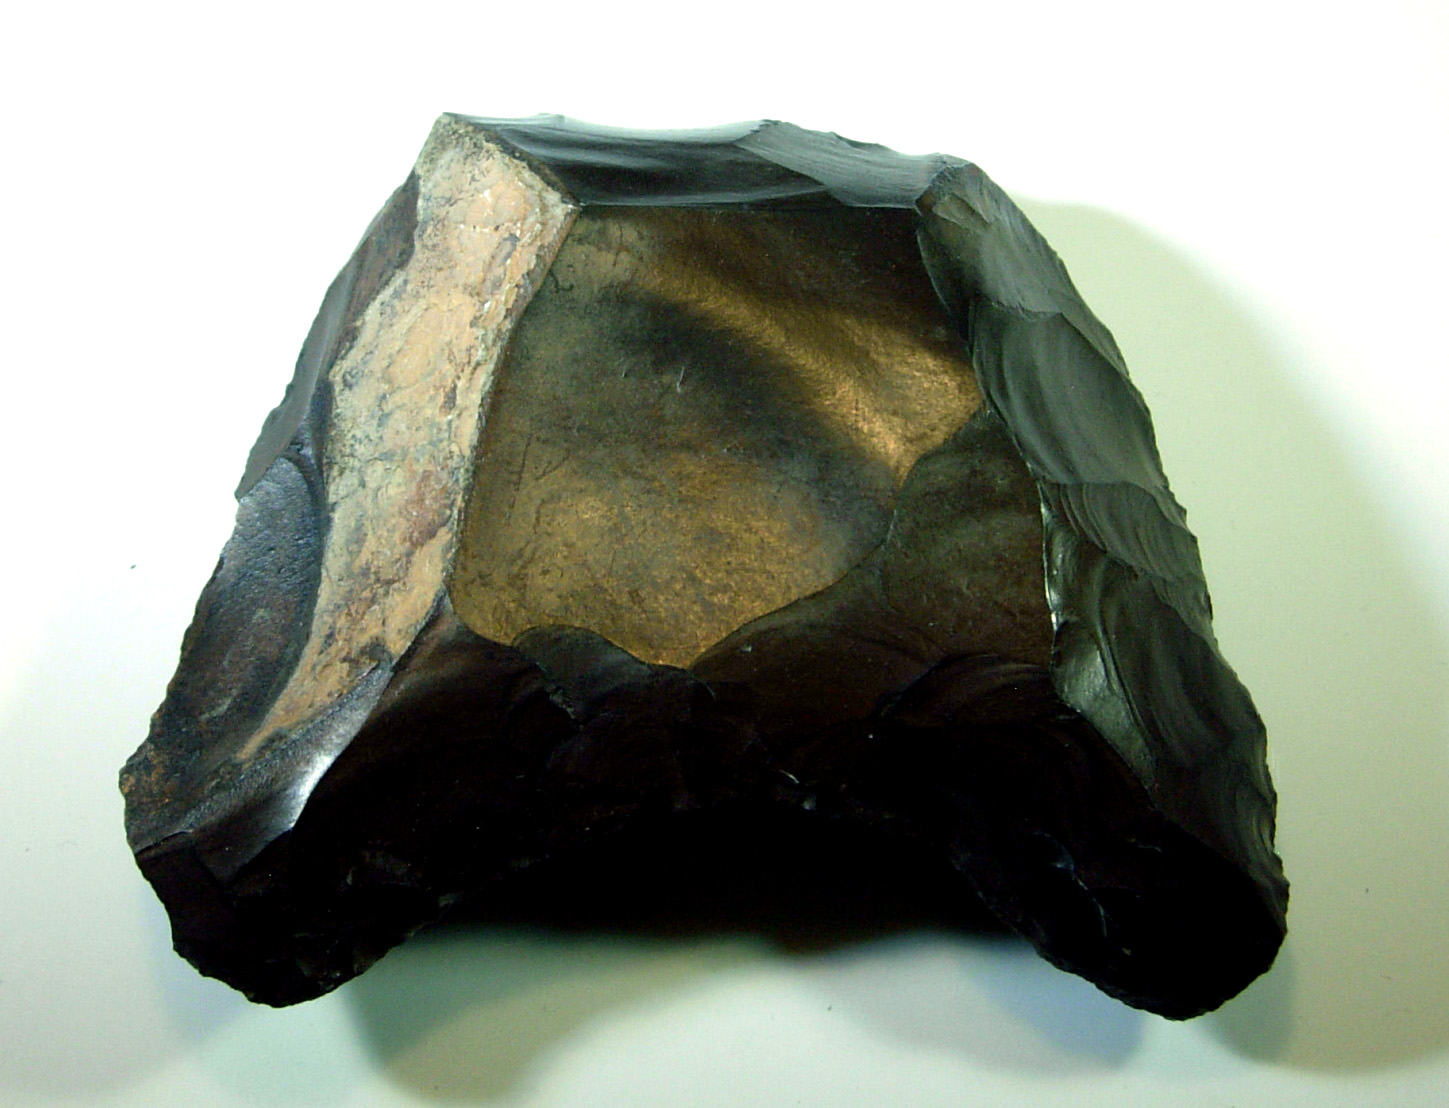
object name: tool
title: Tool (?)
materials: stone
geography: egypt